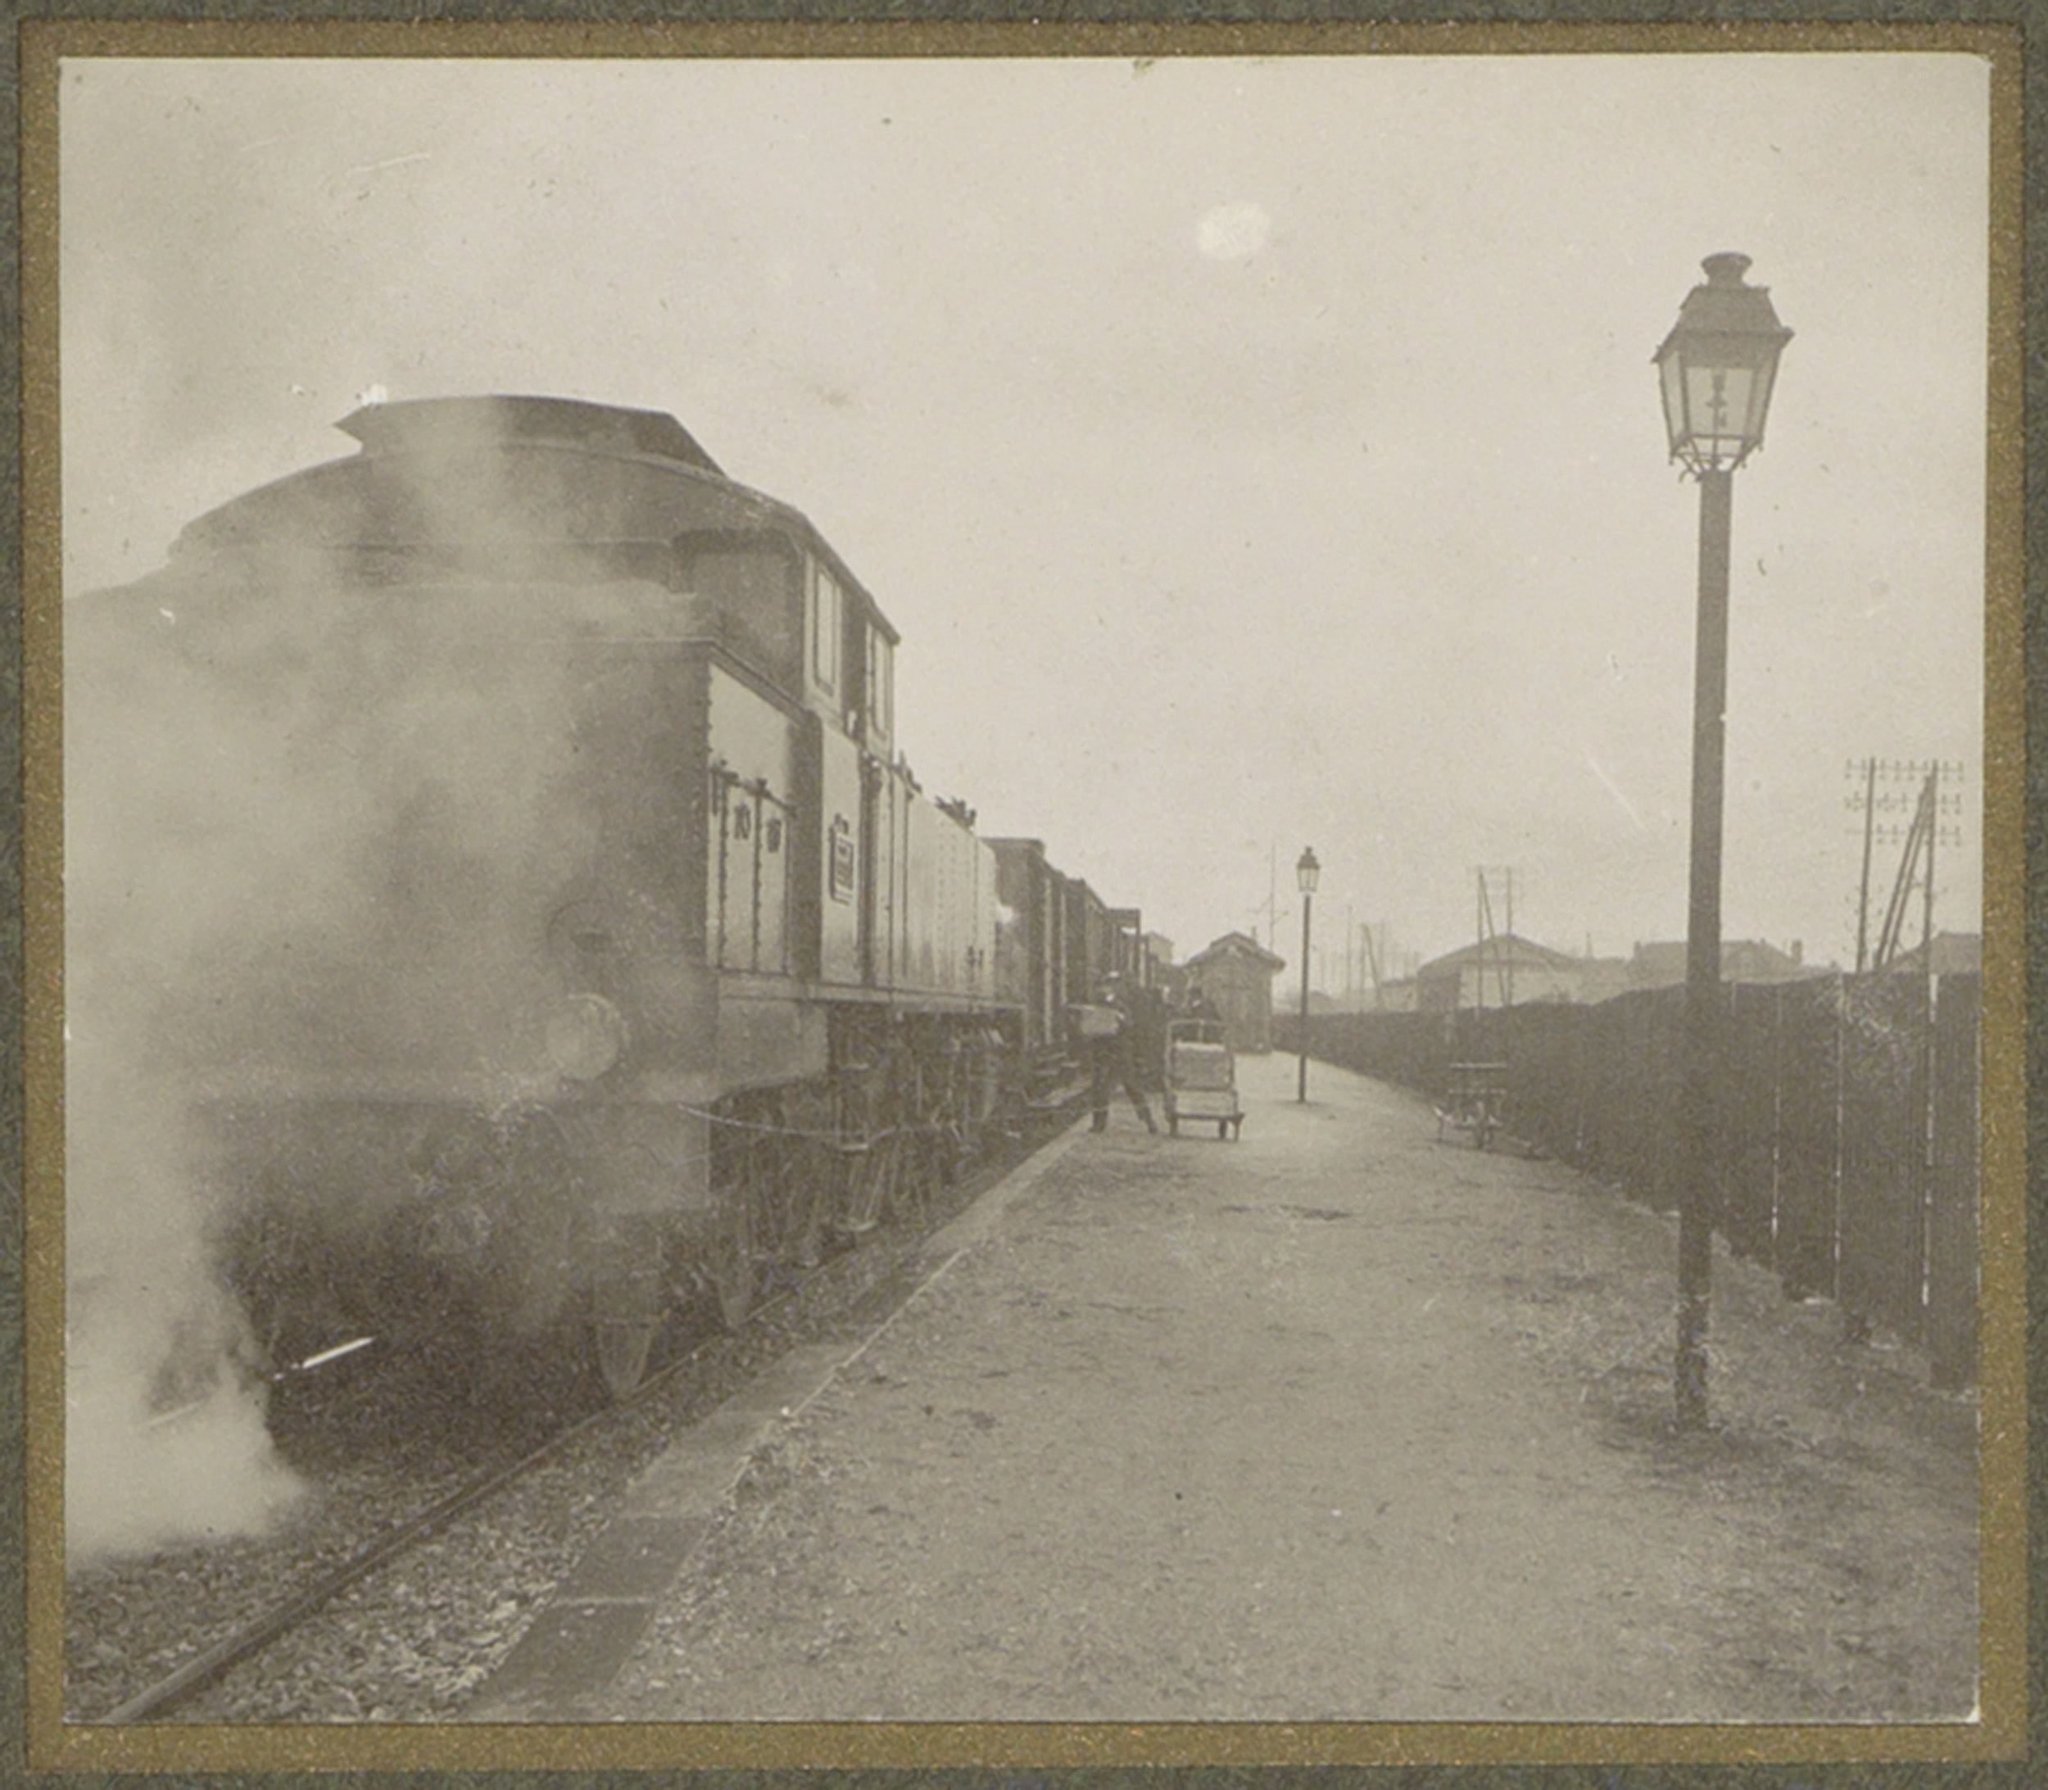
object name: photograph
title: Trein op het perron van Maisons-Alfort tijdens de overstroming van Parijs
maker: g. dangereux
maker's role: fotograaf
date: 1901-1910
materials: photographic support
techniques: matte daylight collodion silver print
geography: paris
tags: flood (+ landscape with figures, staffage), platform (railway, tramway) (+ propulsion of vehicle, ship, etc. by ...), railway, train, steam locomotive, paris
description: Onderdeel van fotoalbum overstroming Parijs en voorsteden 1910.